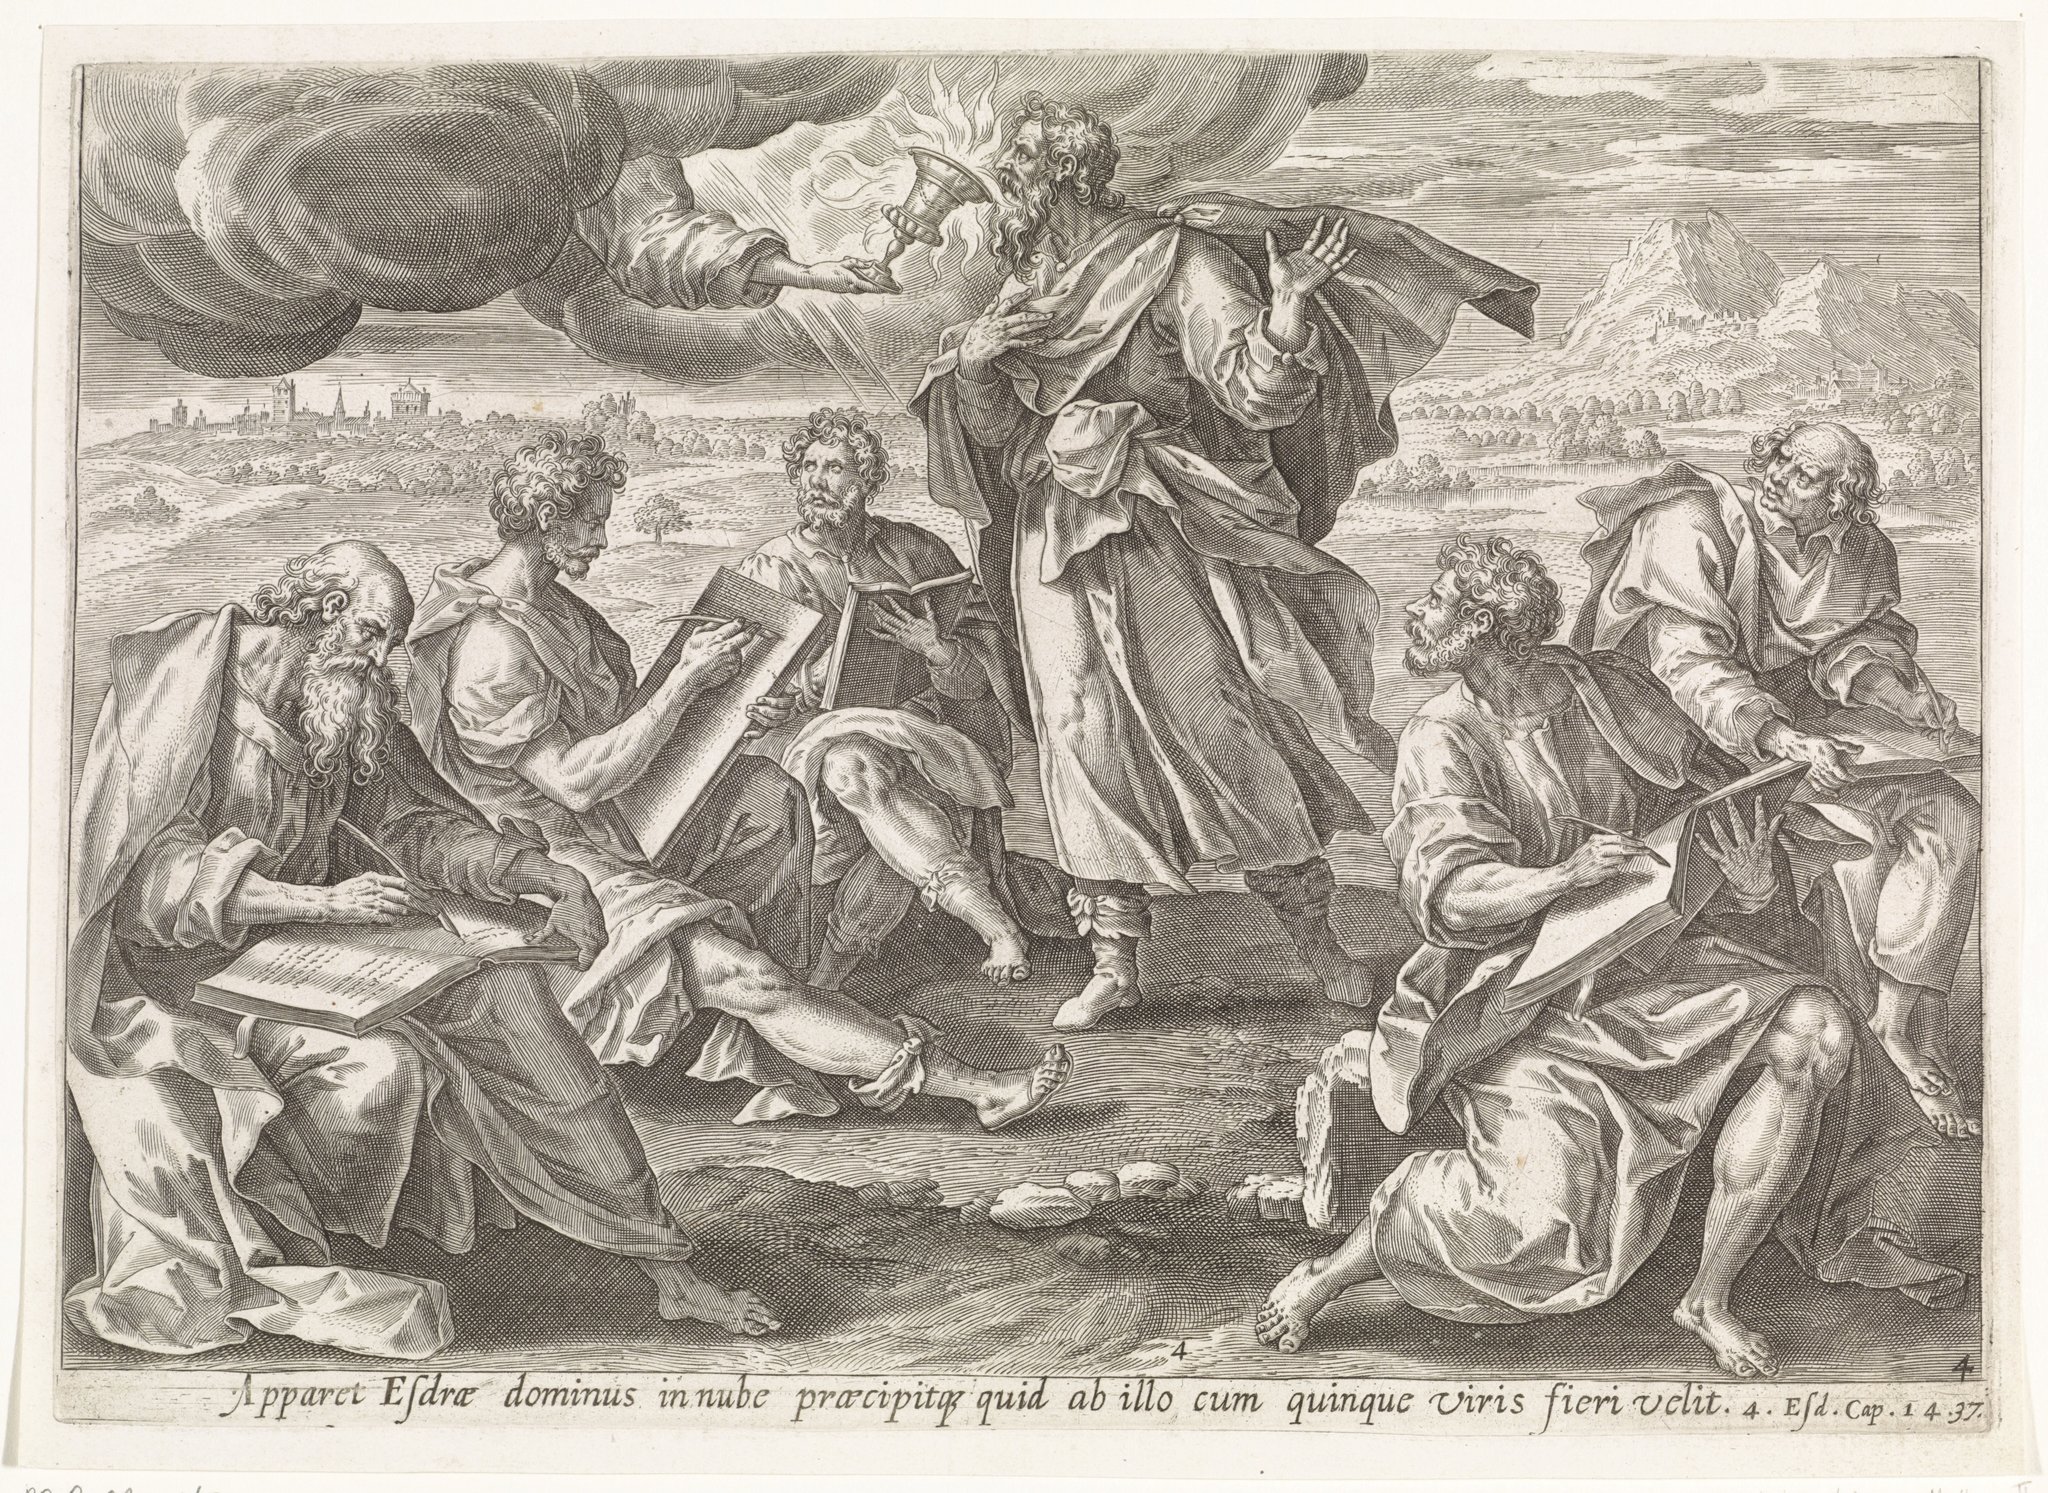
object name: print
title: Ezra drinkt de beker van kennis en wijsheid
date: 1585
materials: paper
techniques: engraving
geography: amsterdam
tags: other scenes from ezra and esdras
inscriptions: collector's mark: Lugt 2228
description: Ezra is met vijf mannen naar het veld gegaan en krijgt daar van God een vurige beker aangeboden waaruit hij drinkt. Dit is de beker van kennis en wijsheid. De vijf mannen schrijven de woorden op die Ezra hierna zegt. Onder de voorstelling een verwijzing in het Latijn naar de apocriefe Bijbeltekst in 4 Ezra 14.